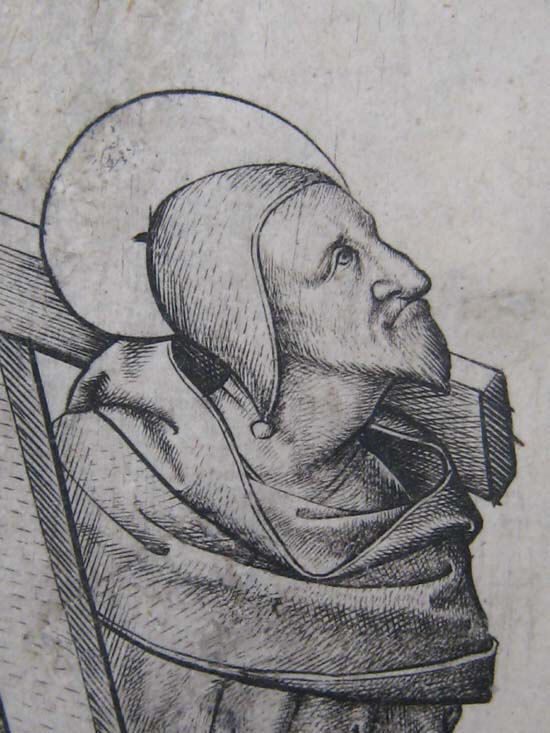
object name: print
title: Saint Judas Thaddeus, from The Apostles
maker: master es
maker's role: artist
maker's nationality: german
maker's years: 1445-1467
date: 1401-1500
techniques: engraving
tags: saints